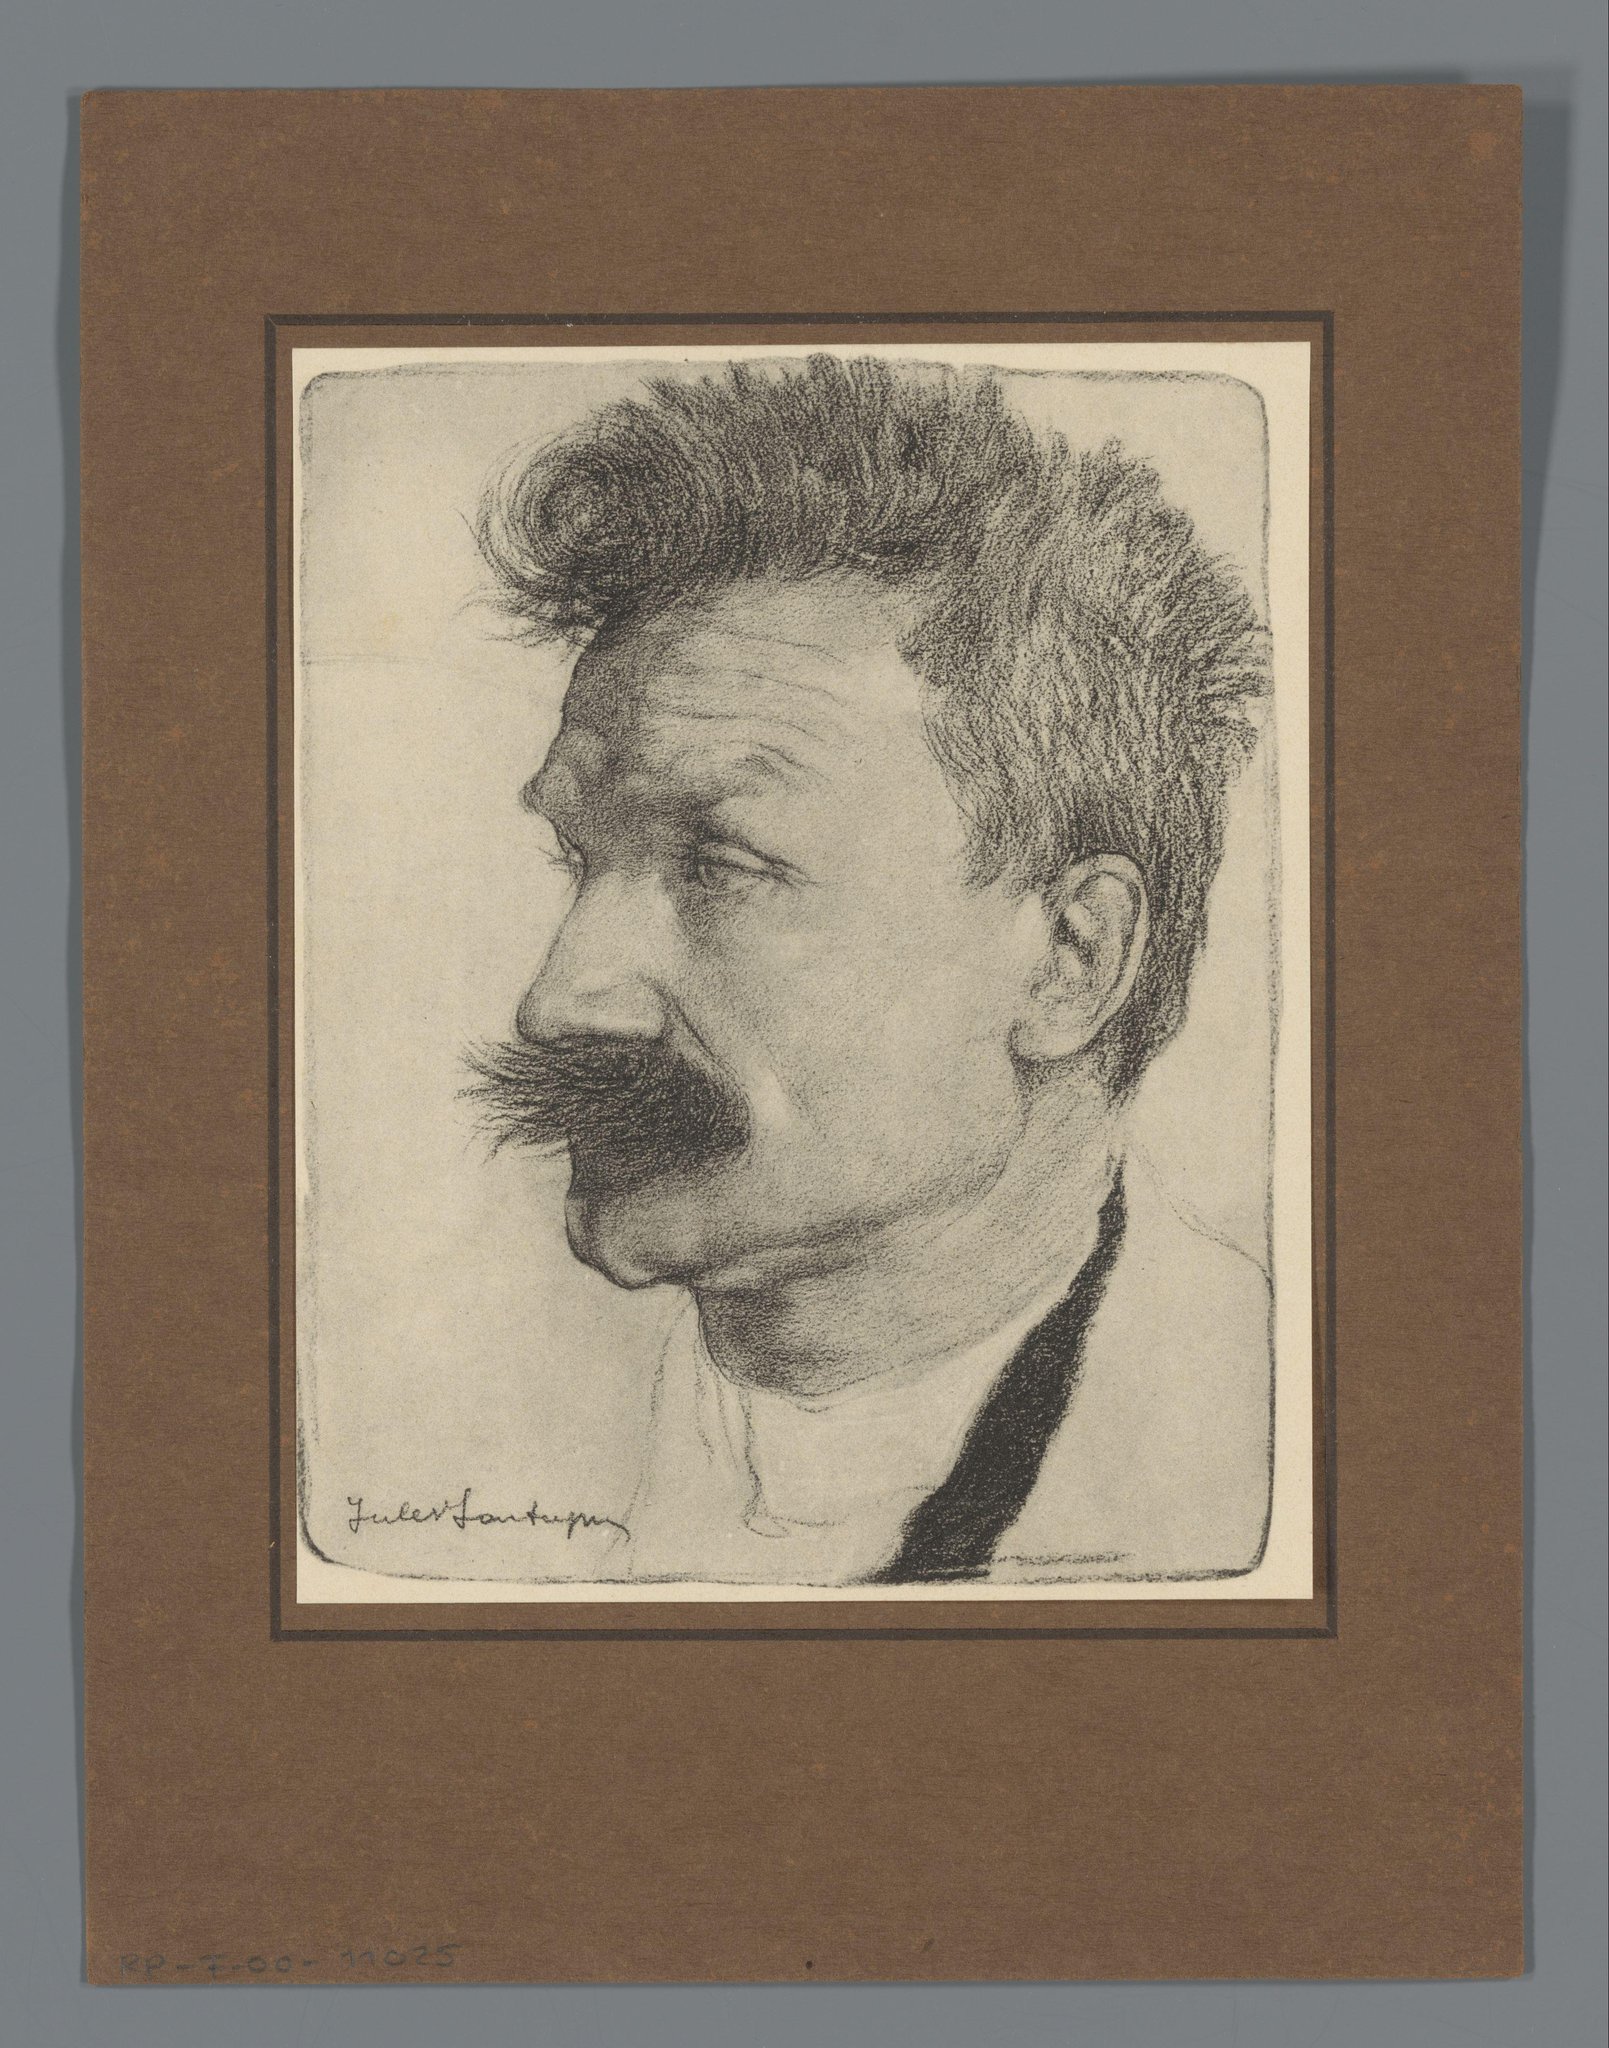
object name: photomechanical print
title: Reproductie van een getekend portret van Stijn Streuvels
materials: paper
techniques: photograph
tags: stijn streuvels, portrait of a writer